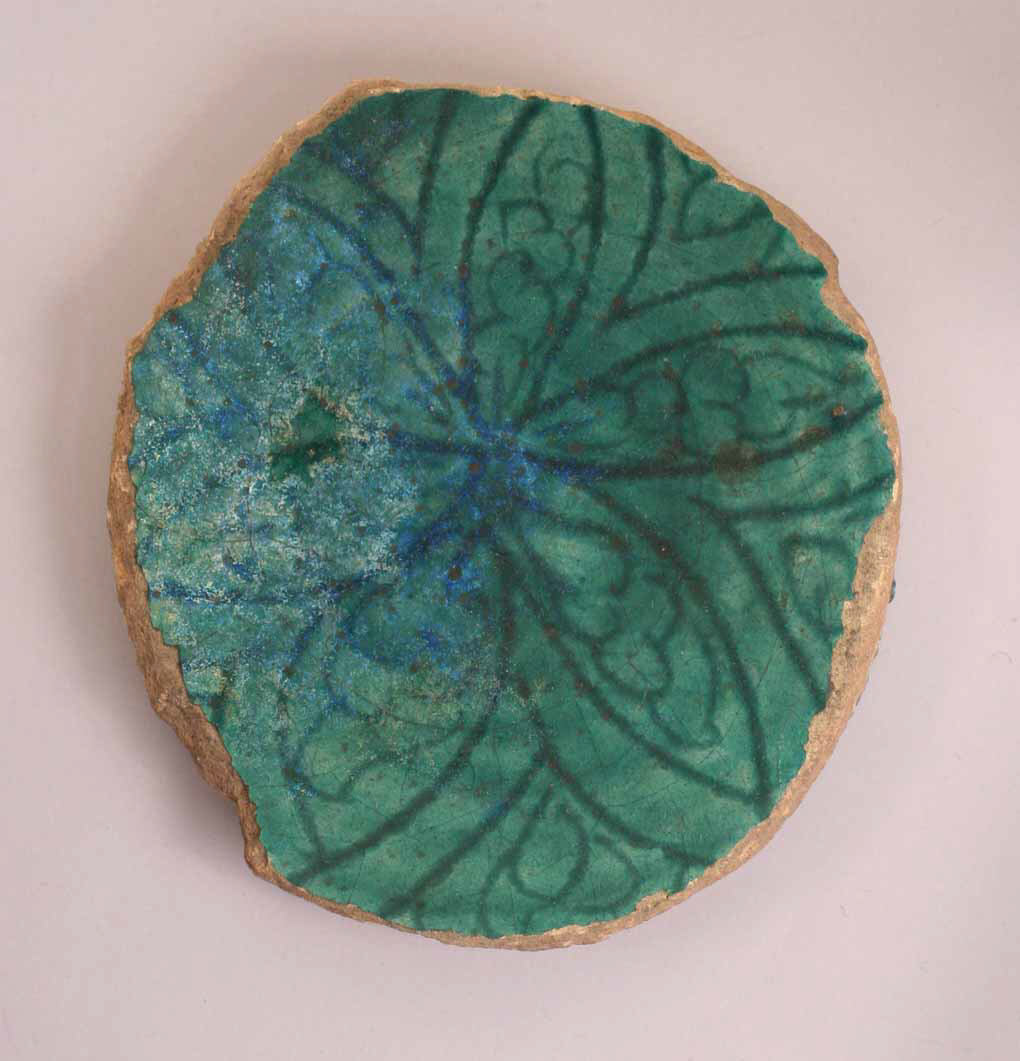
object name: ceramic fragment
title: Fragment of a Dish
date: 1201-1400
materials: earthenware, glaze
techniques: incising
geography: egypt